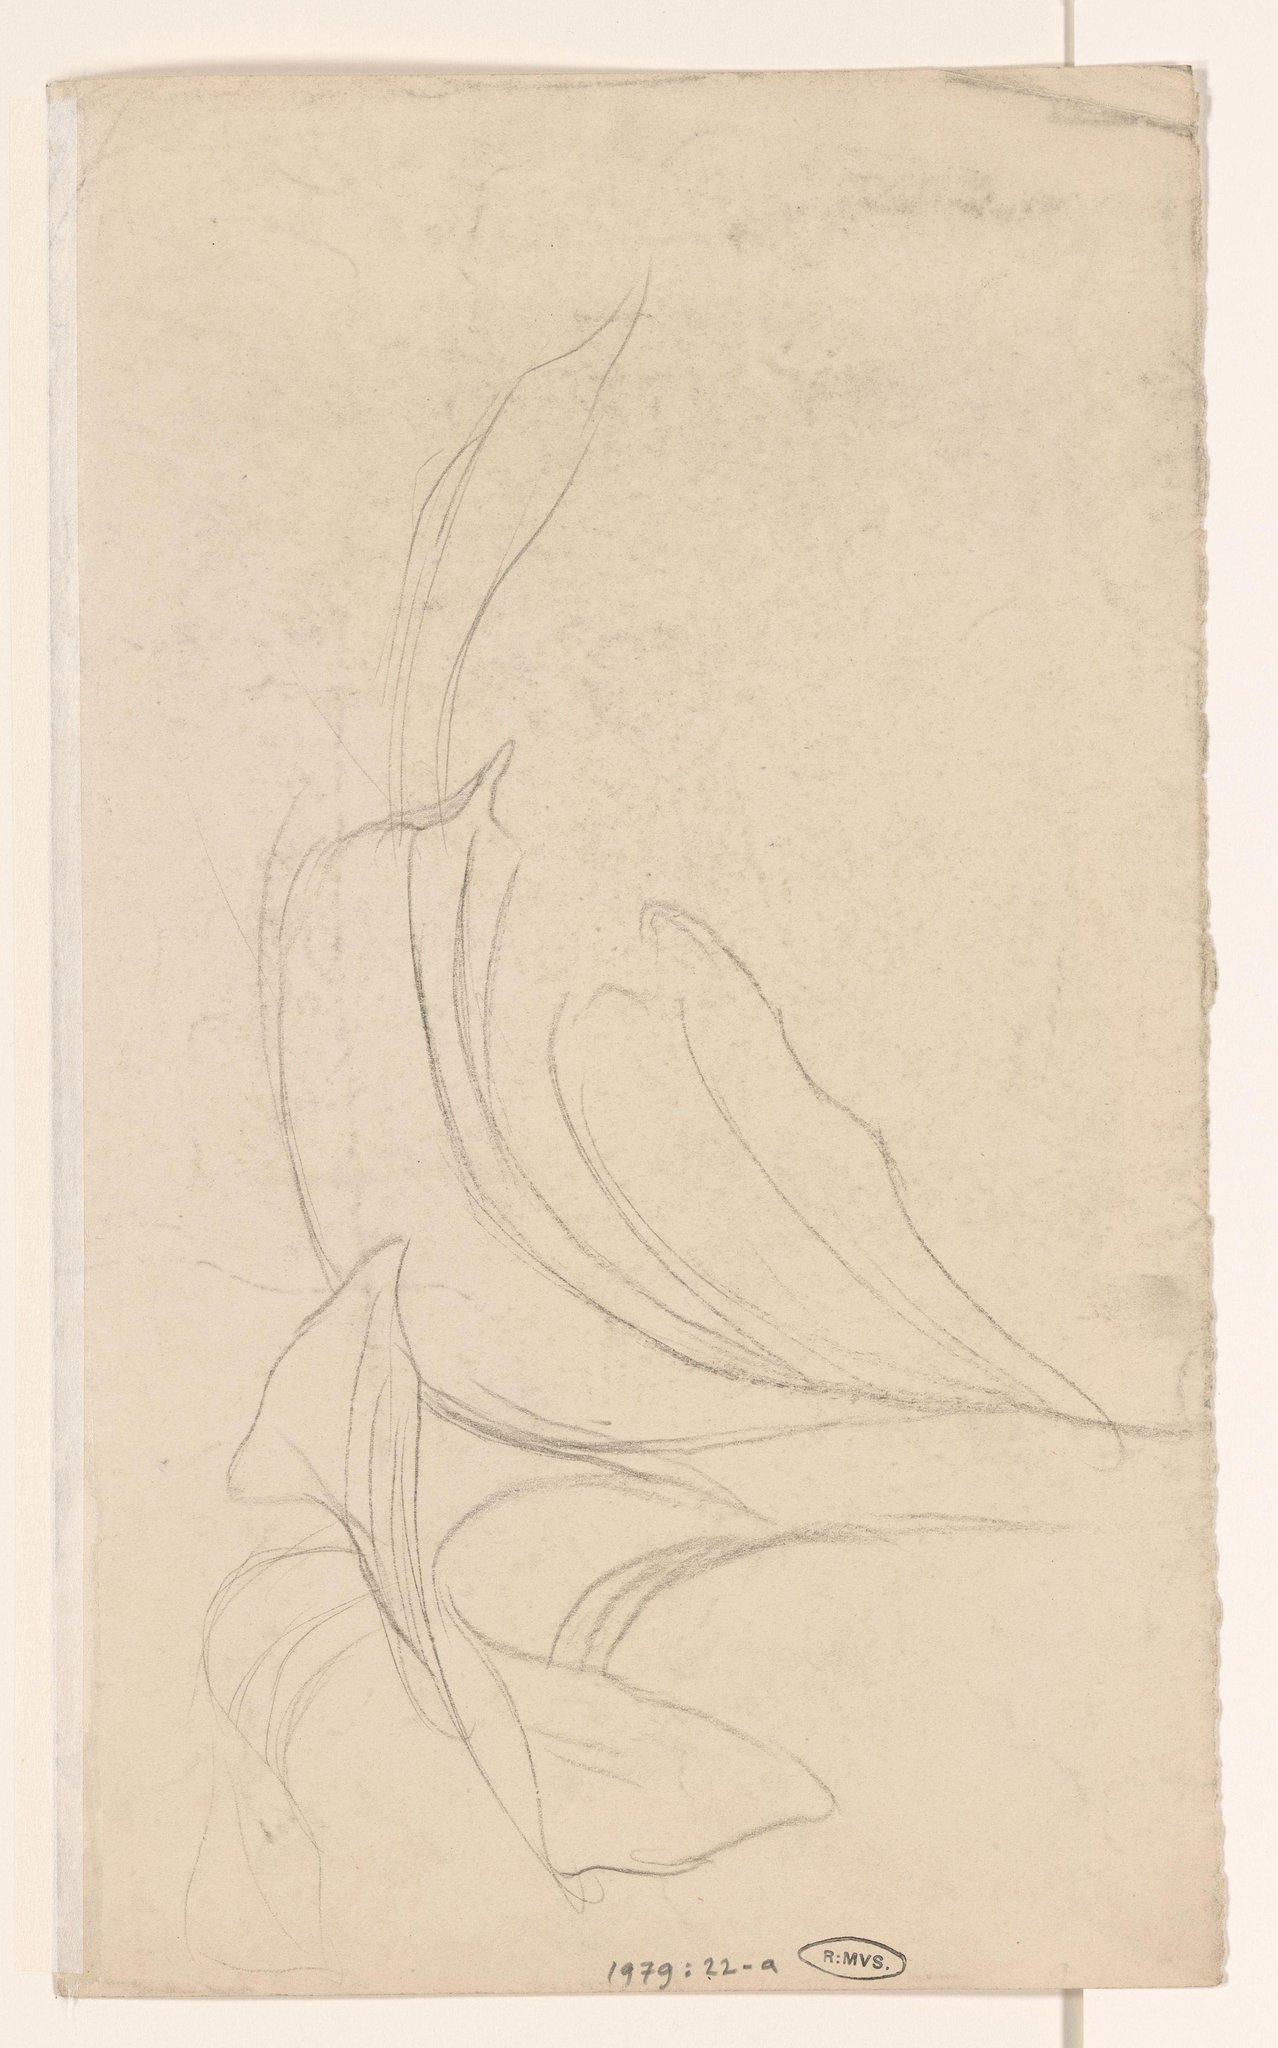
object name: drawing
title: Plantstudie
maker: wilhelmus johannes steenhoff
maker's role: draughtsman, print maker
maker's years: 1863-1932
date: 1873-1932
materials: chalk, paper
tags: plants and herbs